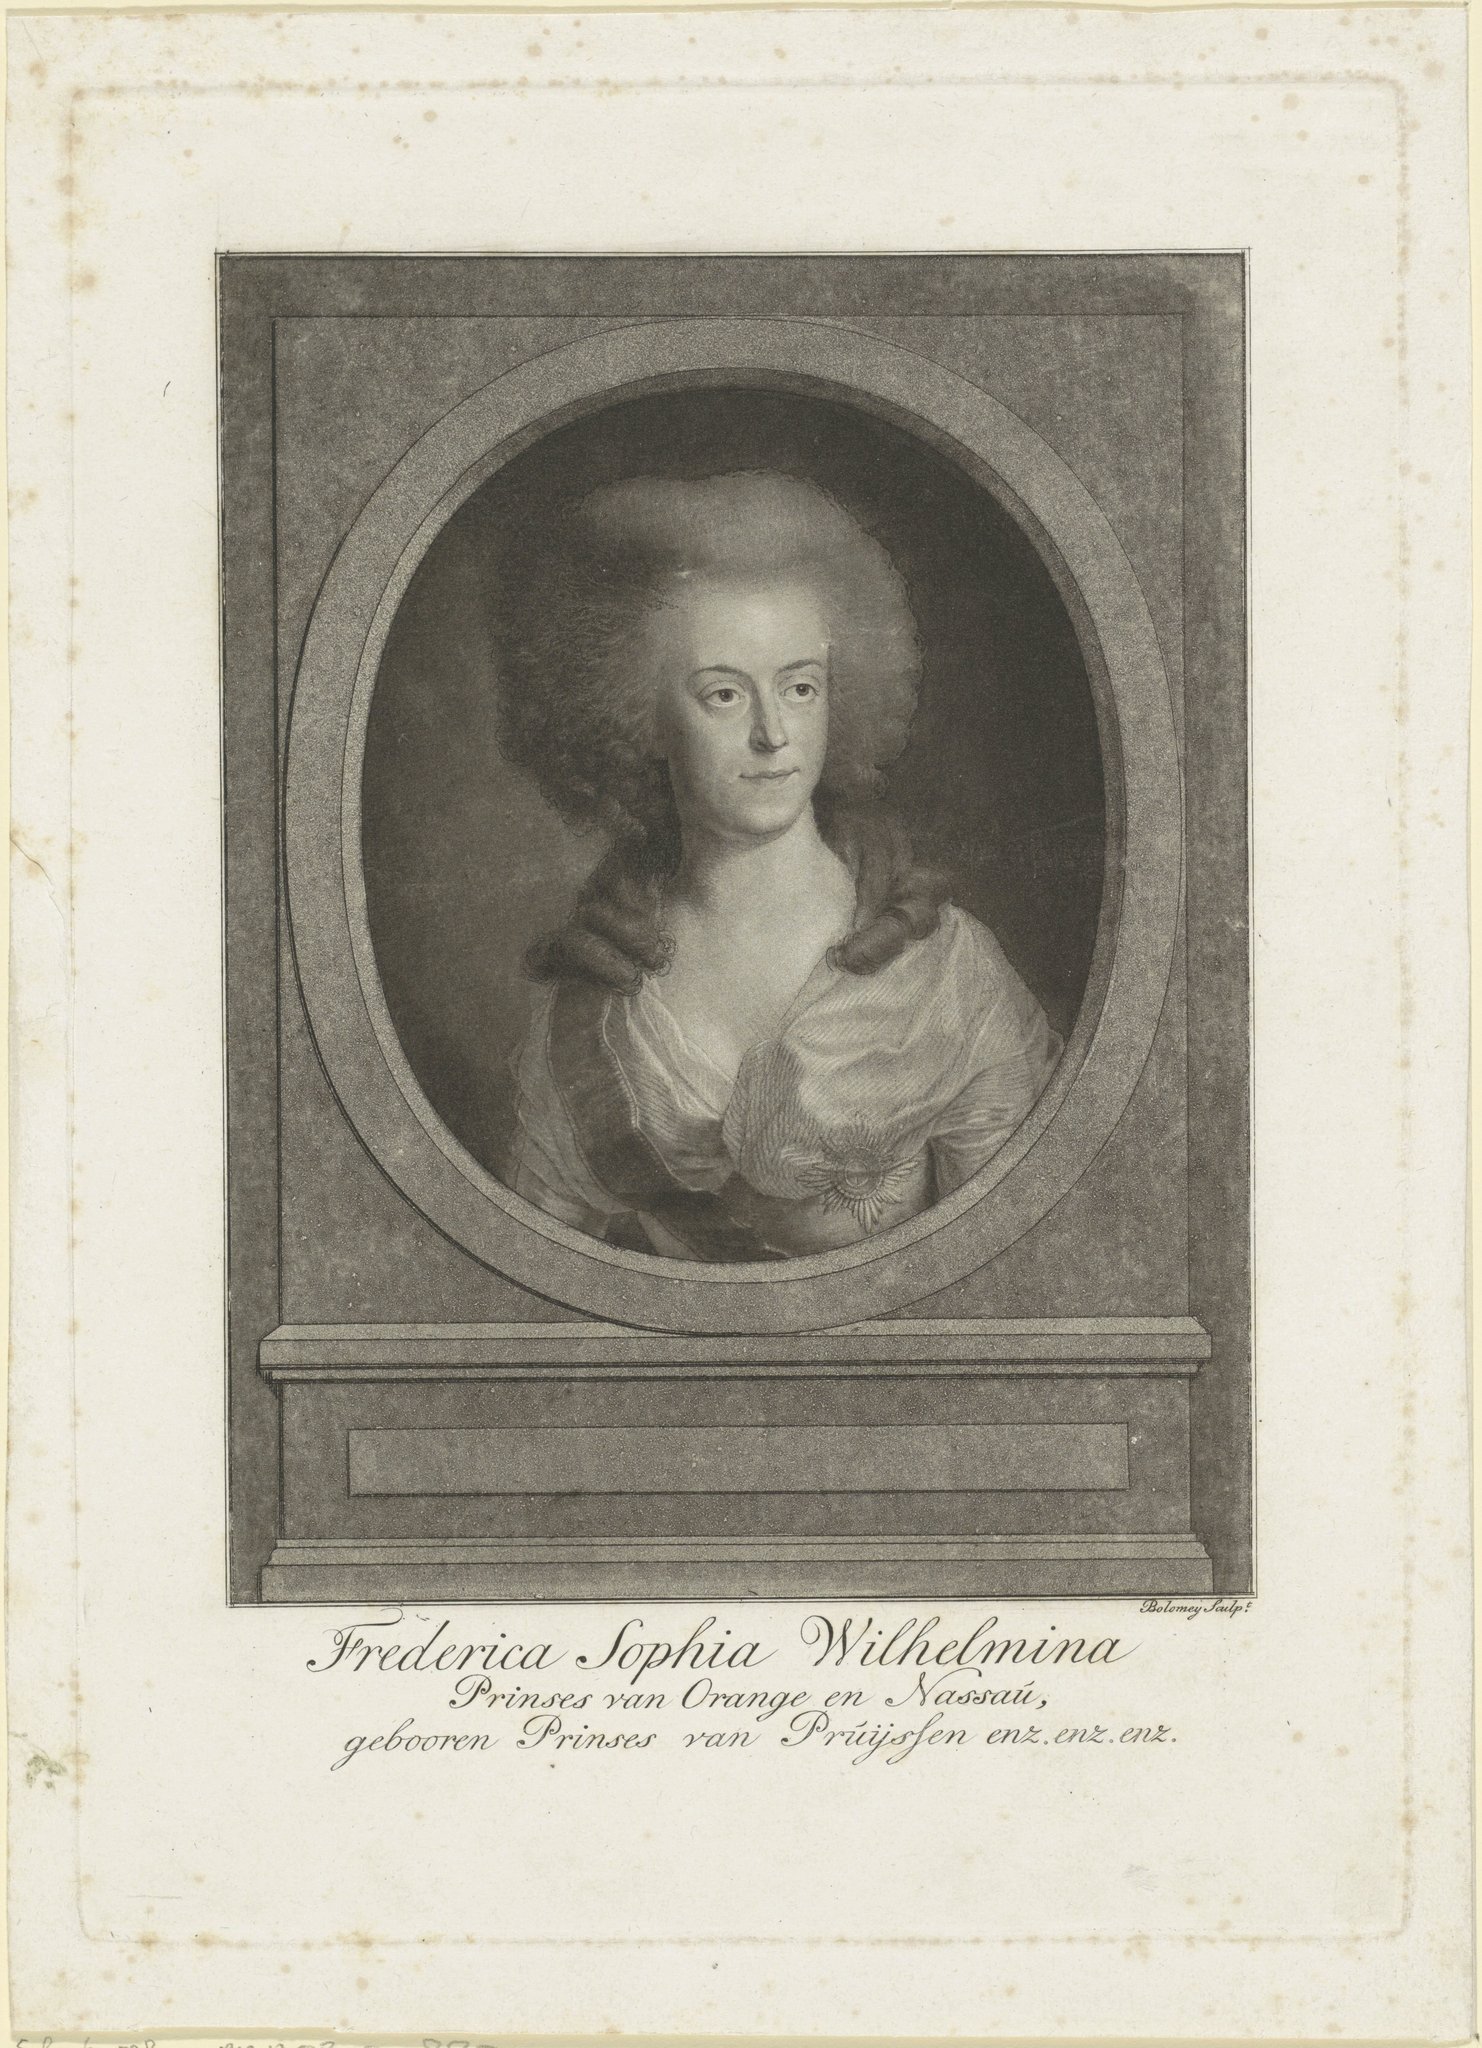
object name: print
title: Portret van Wilhelmina van Pruisen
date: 1767-1819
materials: paper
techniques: aquatint, etching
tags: berlin, painter, draughtsman, wilhelmina of prussia (princess of orange)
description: Portret van Wilhelmina in een ovaal. In de ondermarge haar naam en titels.